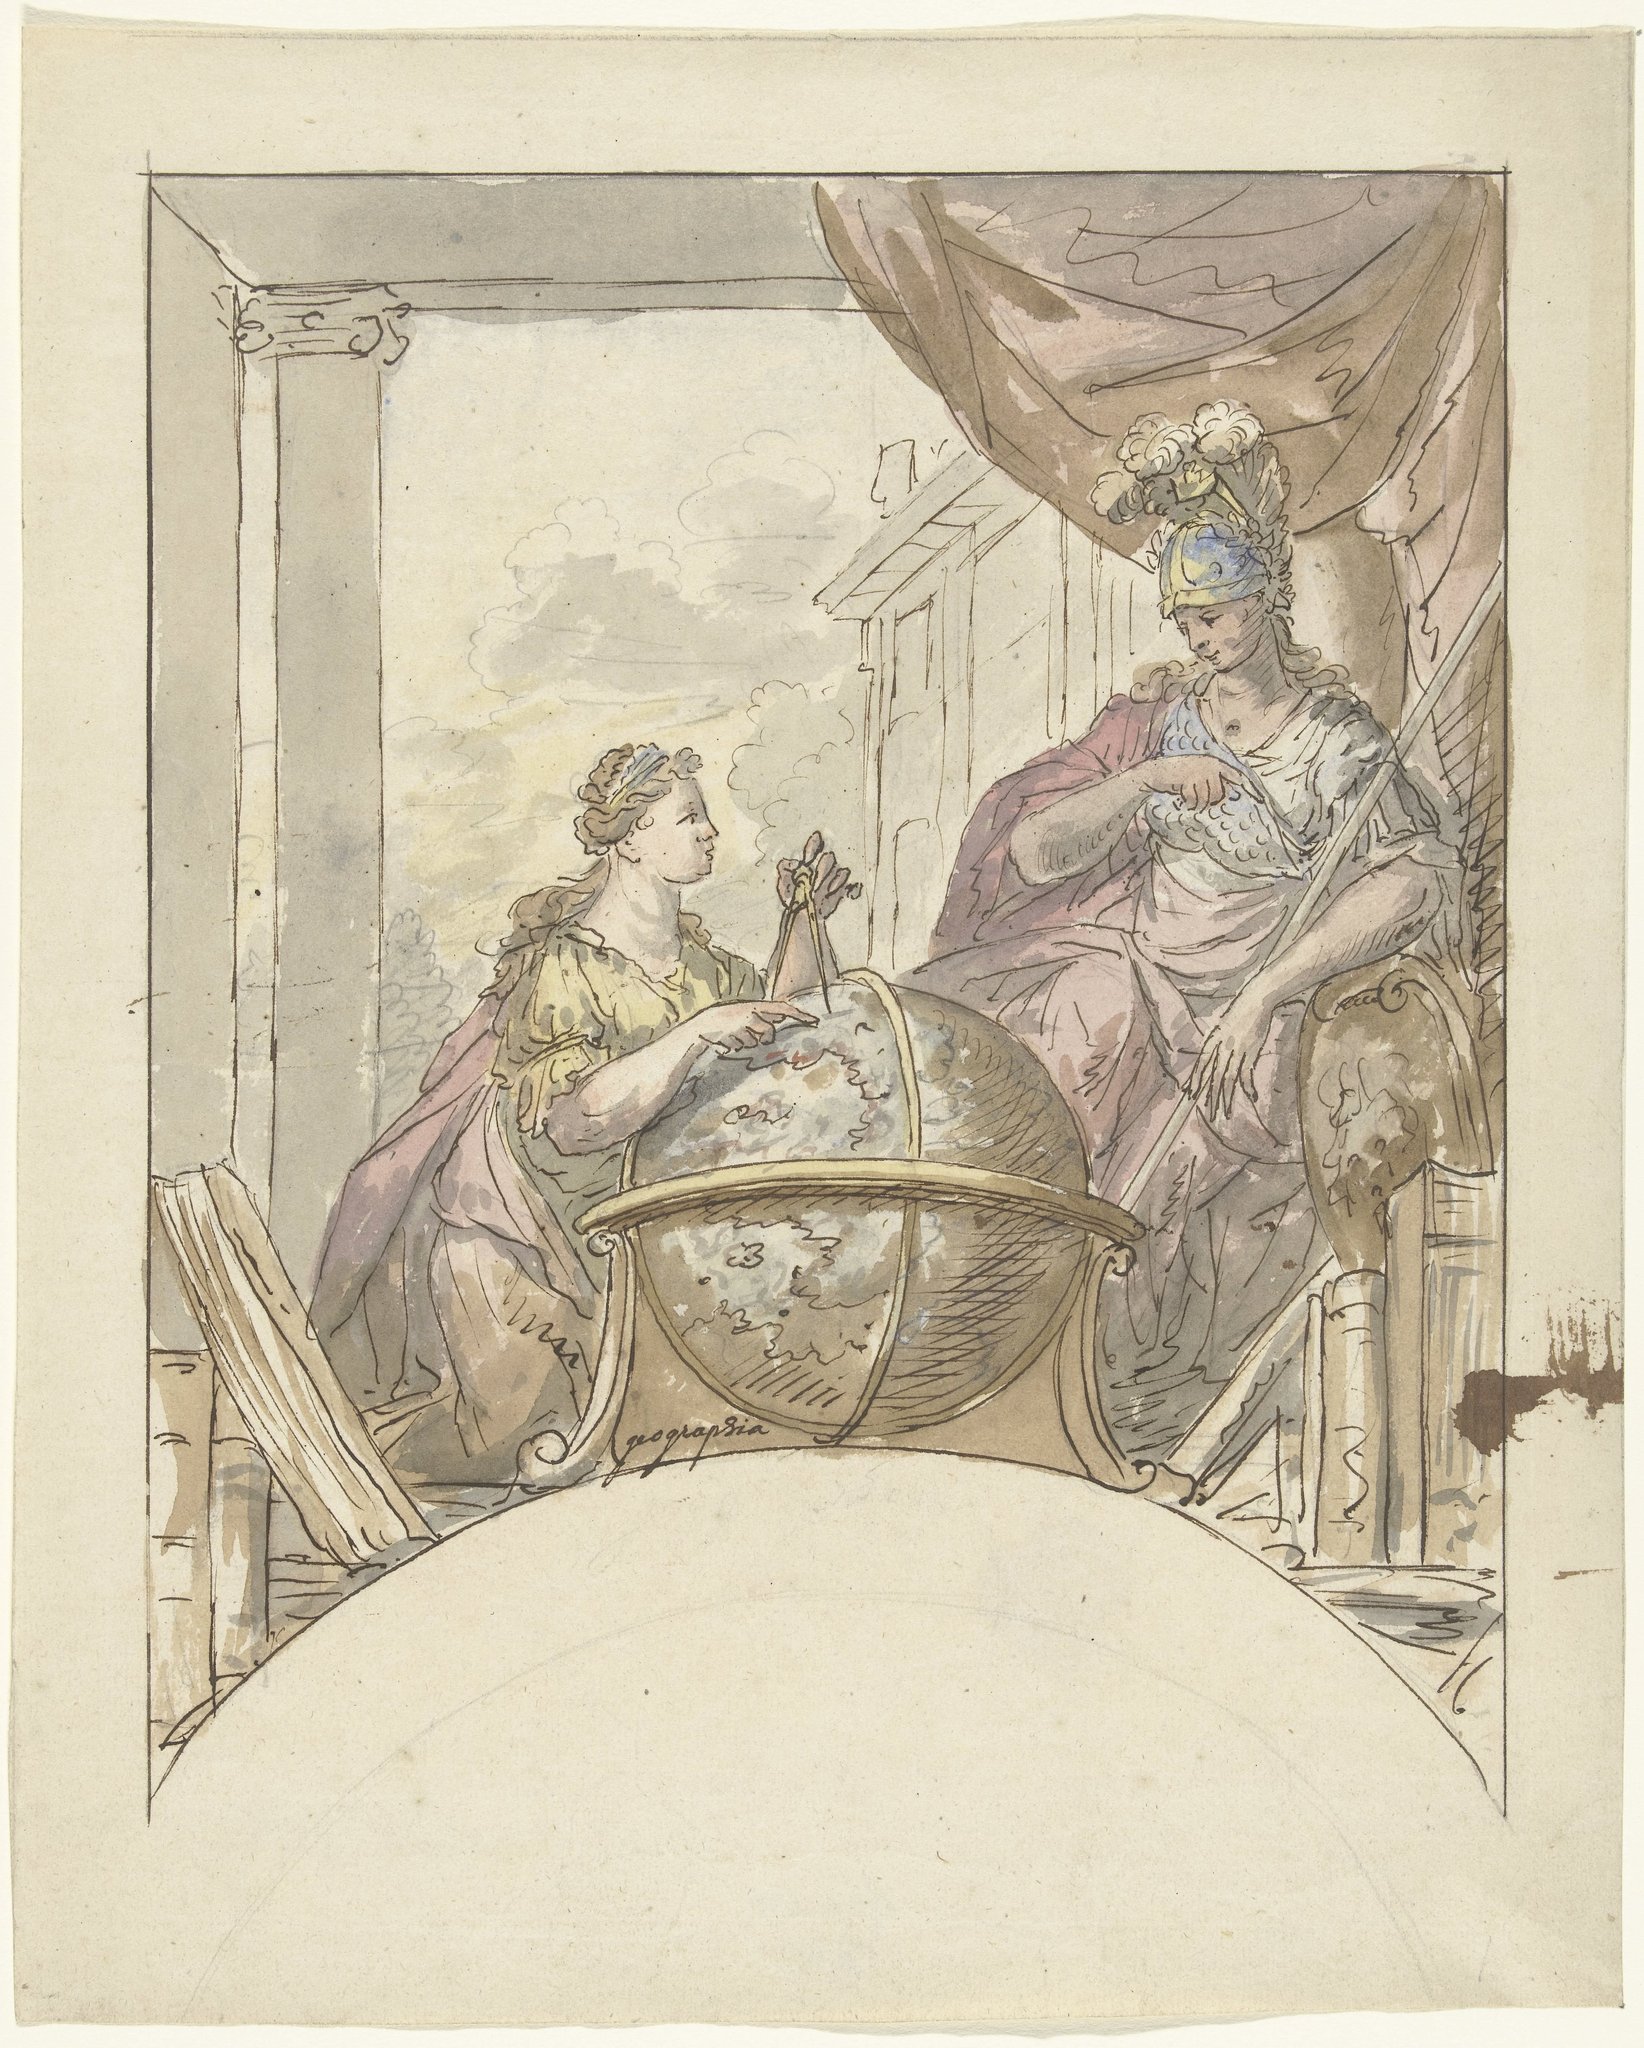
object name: watercolor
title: Geographie en Minerva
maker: elias van nijmegen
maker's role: draughtsman, painter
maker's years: 1667-1755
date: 1677-1755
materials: ink, paper, pencil, watercolor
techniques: brush, pen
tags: 'geografia', minerva as patroness